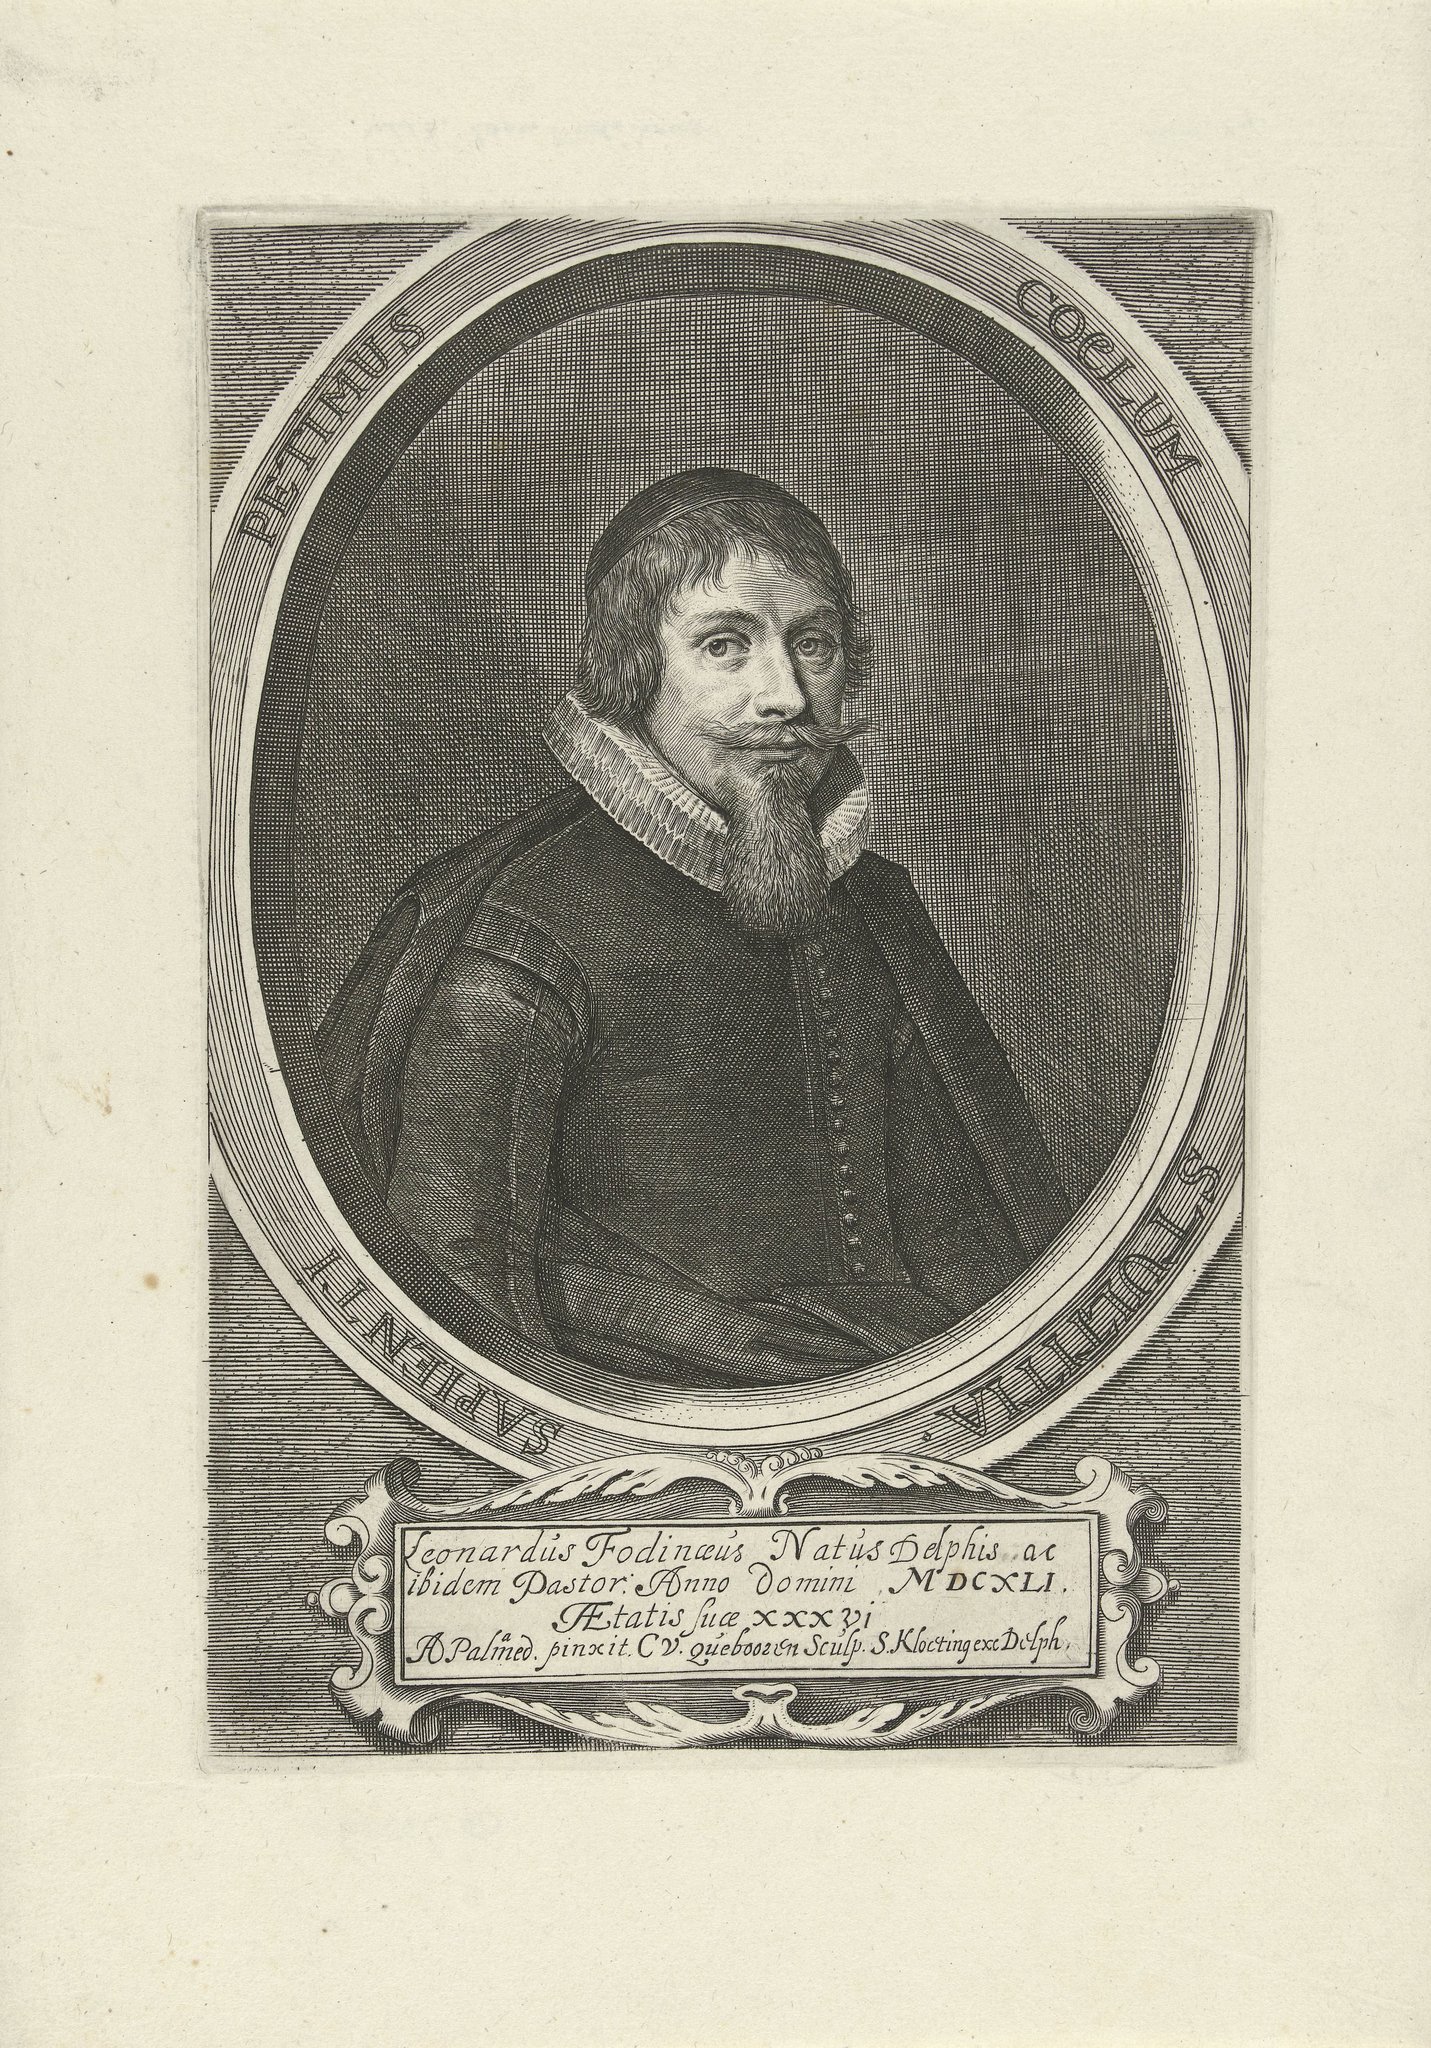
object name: print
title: Portret van Leonardus Fodinaeus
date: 1641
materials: paper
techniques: engraving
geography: the hague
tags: delft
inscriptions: collector's mark: Lugt 240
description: Portret van Leonardus Fodinaeus, predikant te Wormer en Delft. In de omlijsting zijn motto in het Latijn. Onder het portret zijn naam en titels.